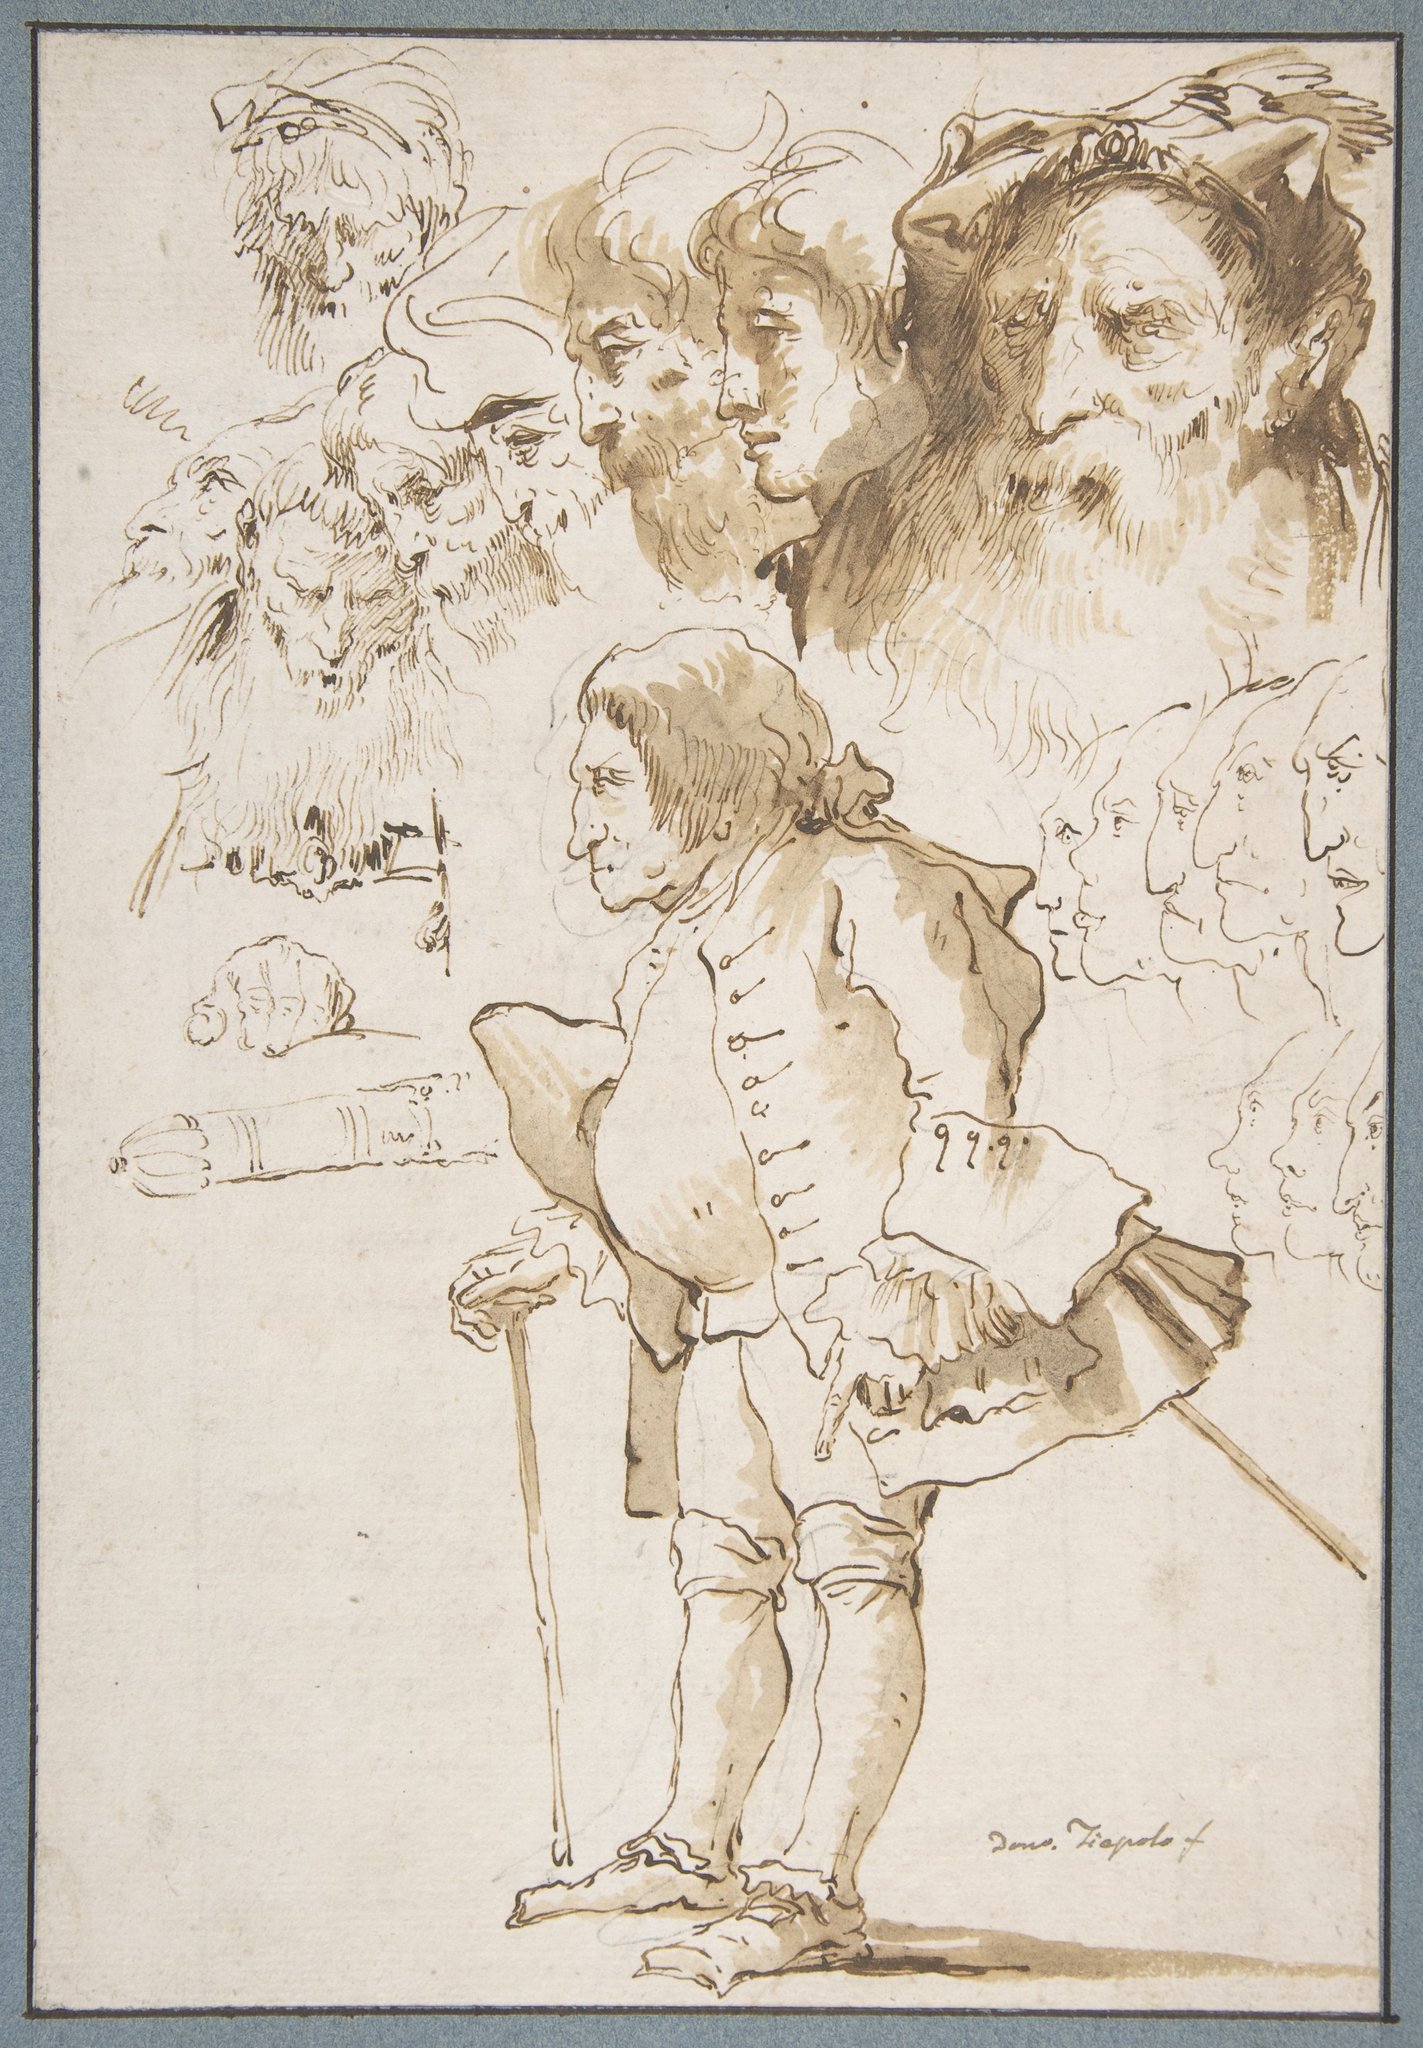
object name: drawing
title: Caricature of a Gentleman and Other Studies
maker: giovanni domenico tiepolo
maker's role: artist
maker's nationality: italian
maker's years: 1727-1804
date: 1727-1804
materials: chalk, ink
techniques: brush, pen, wash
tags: heads,men